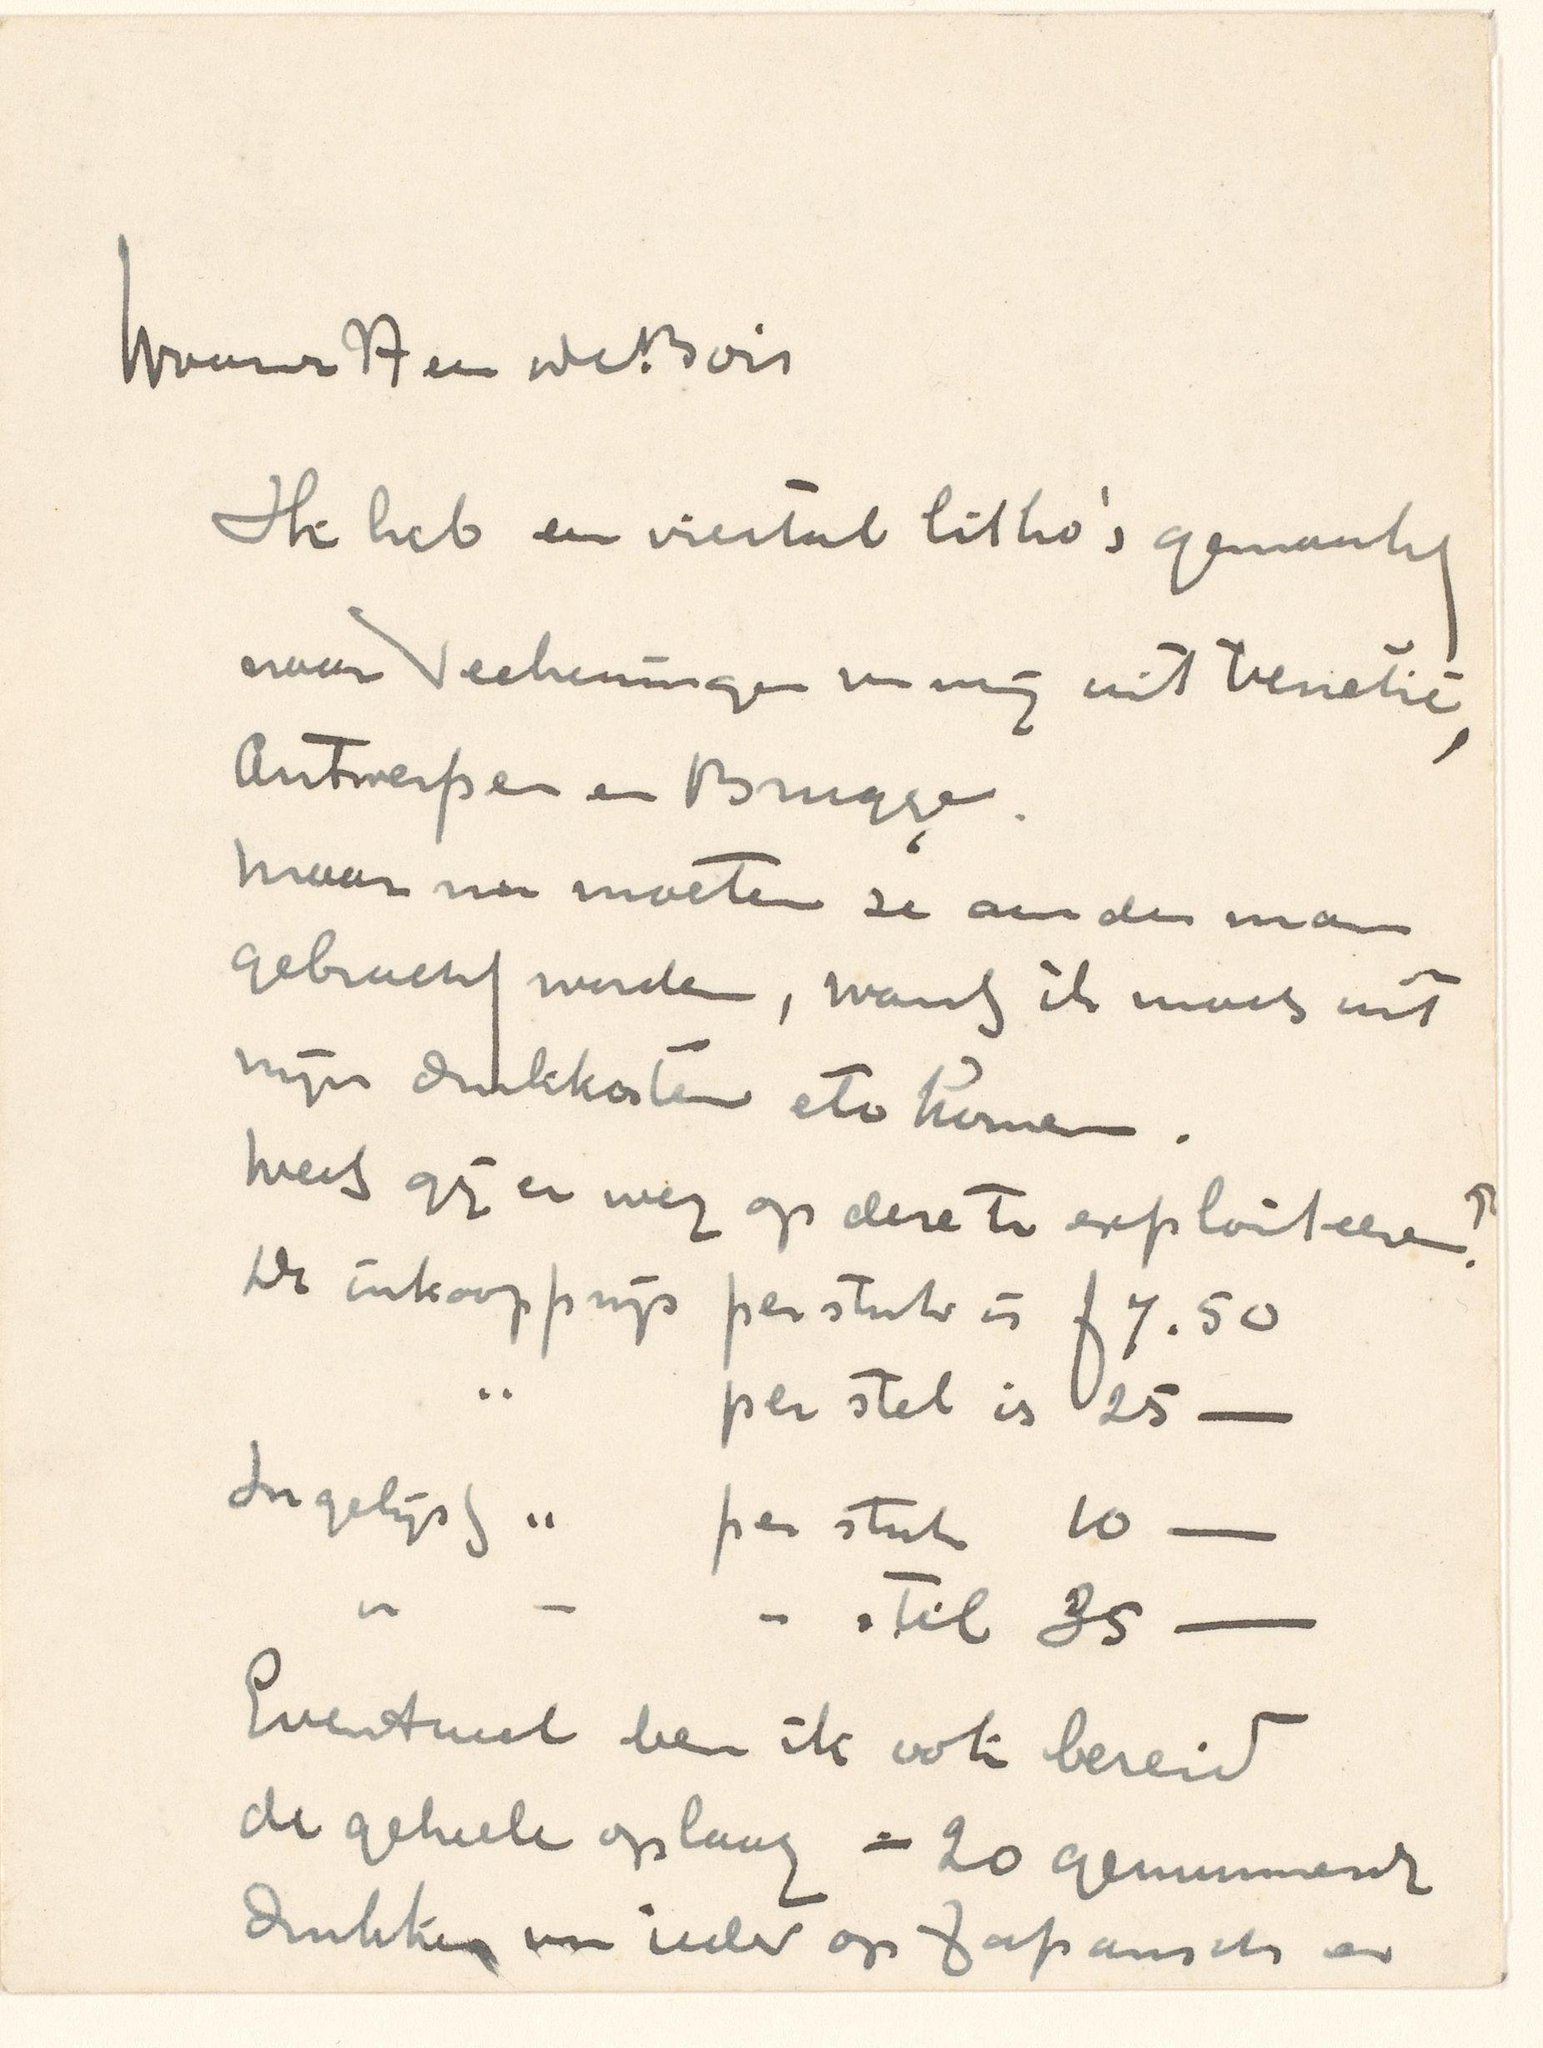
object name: letter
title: Brief aan J.H. de Bois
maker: reinier willem petrus de vries (1874-1953)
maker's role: draughtsman, print maker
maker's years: 1874-1953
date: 1884-1952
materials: ink, paper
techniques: pen, writing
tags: haarlem, publisher, johannes henricus de bois, the graphic arts, money